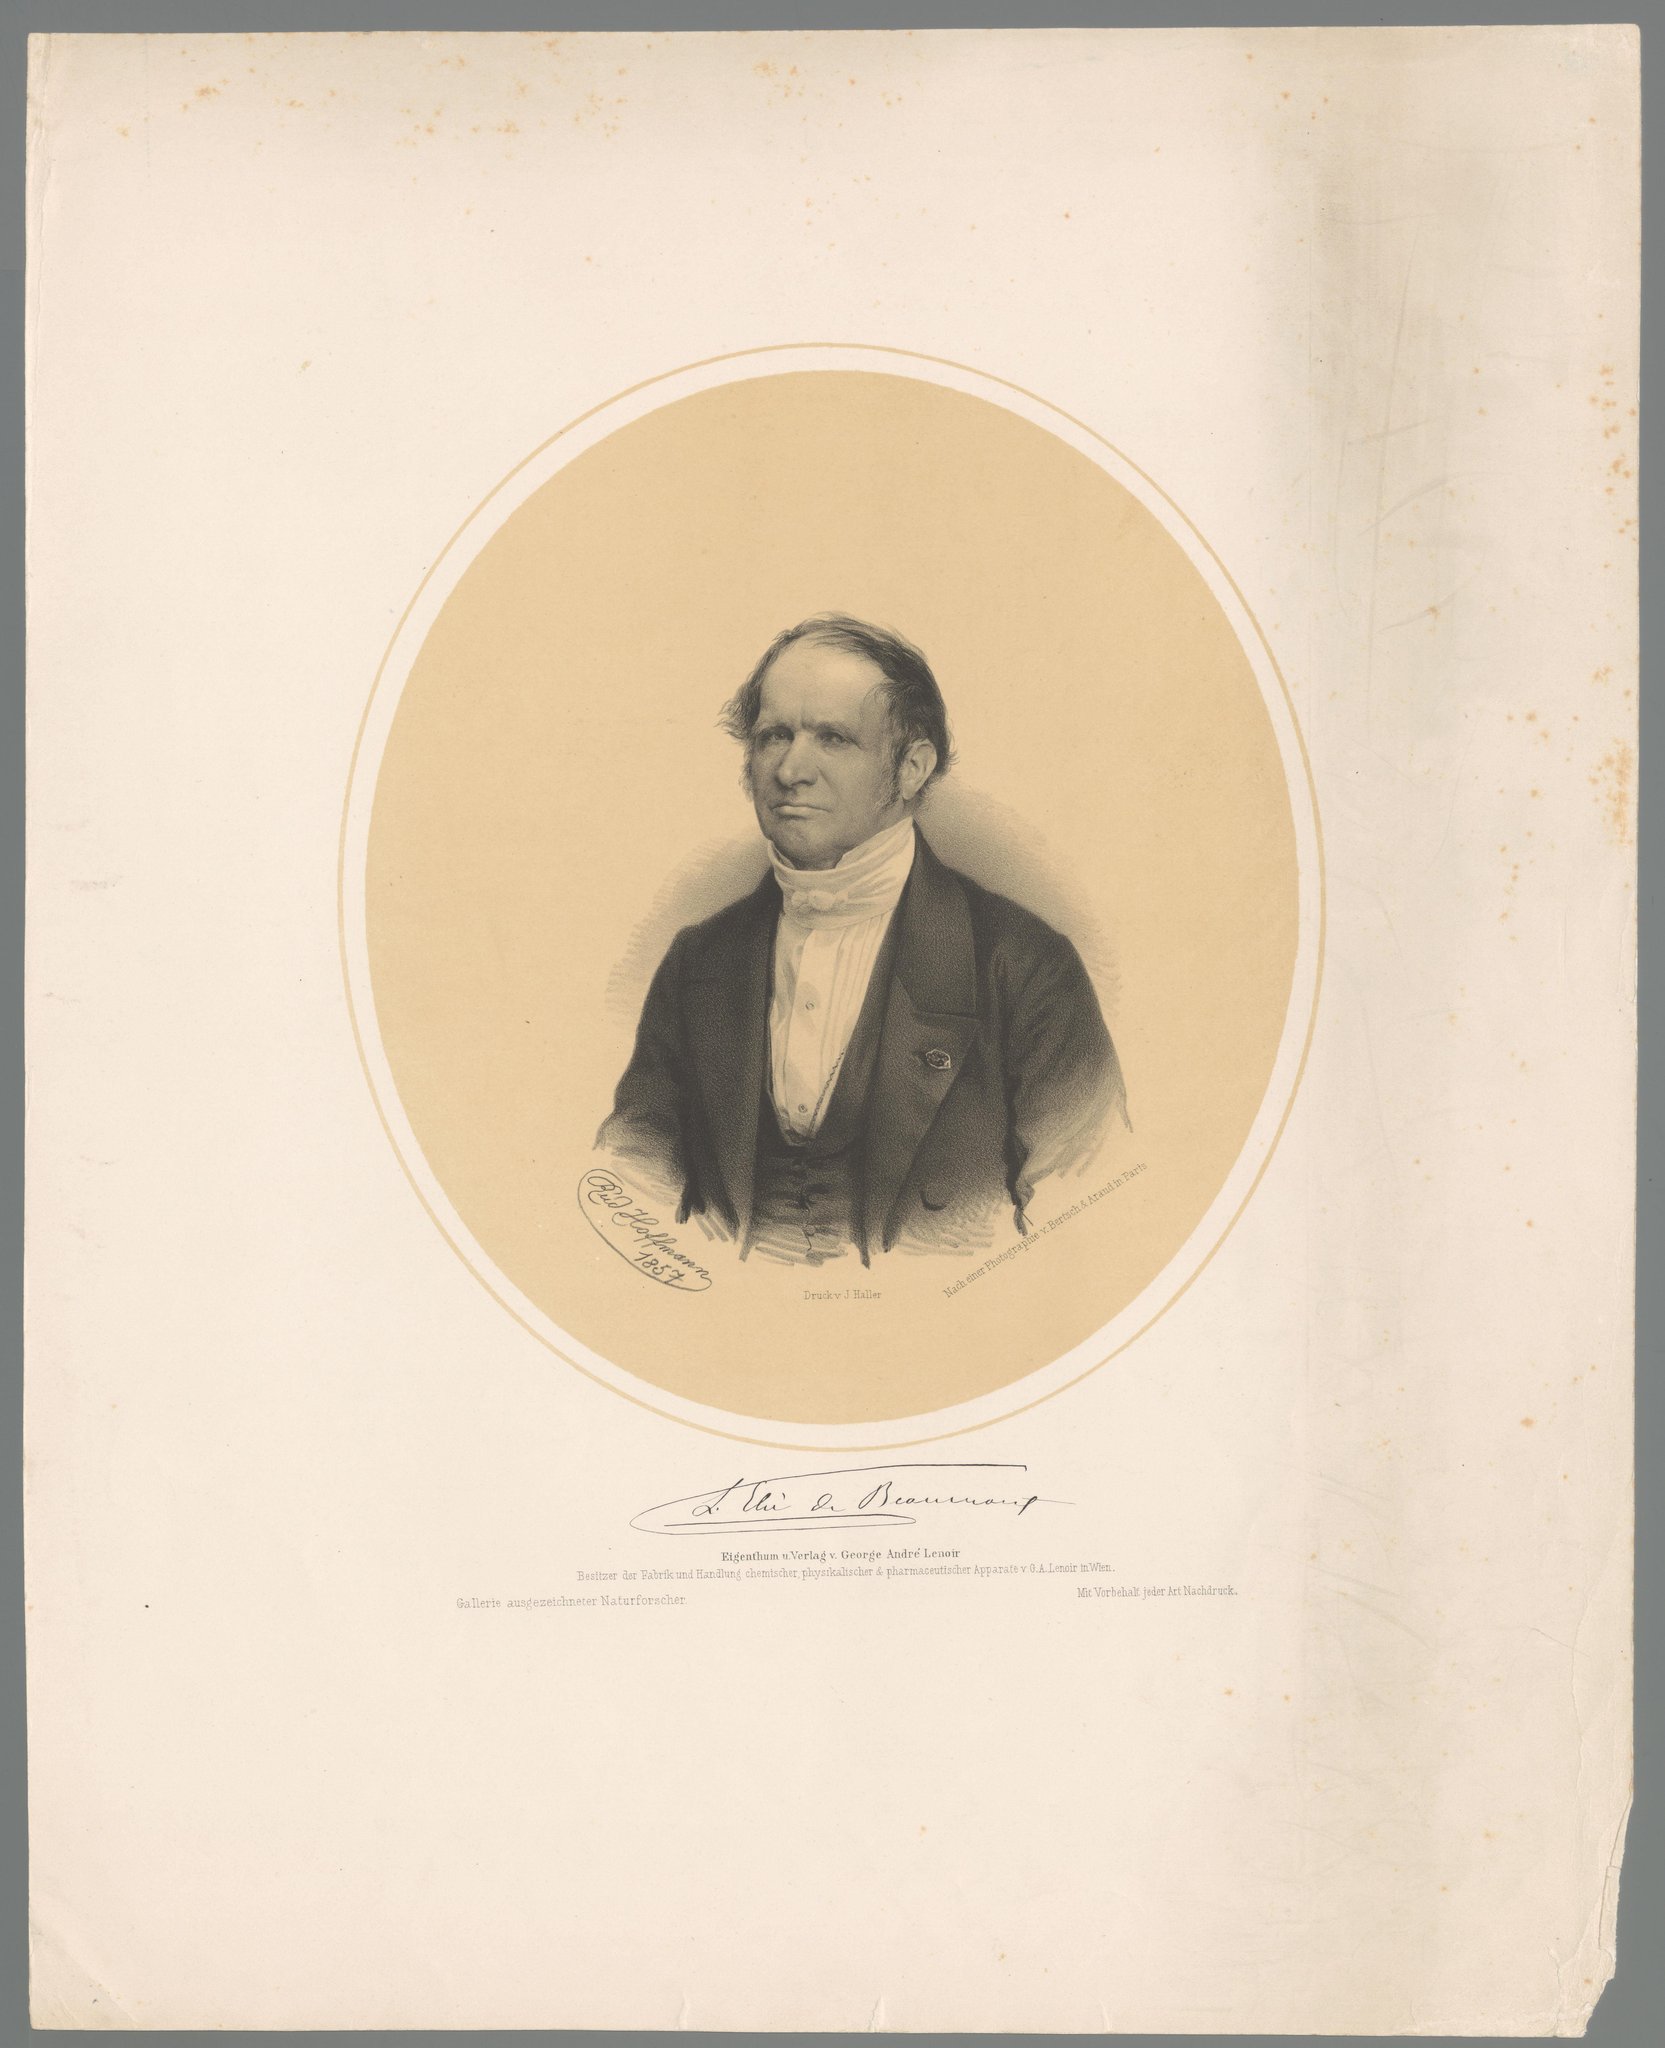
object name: print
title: Portret van Léonce Élie de Beaumont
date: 1857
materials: paper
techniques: tone lithography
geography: vienna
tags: adult man, historical persons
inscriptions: date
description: Deze prent behoort tot een serie met 100 portretten van natuurwetenschappers, uitgegeven tussen 1856-1860.